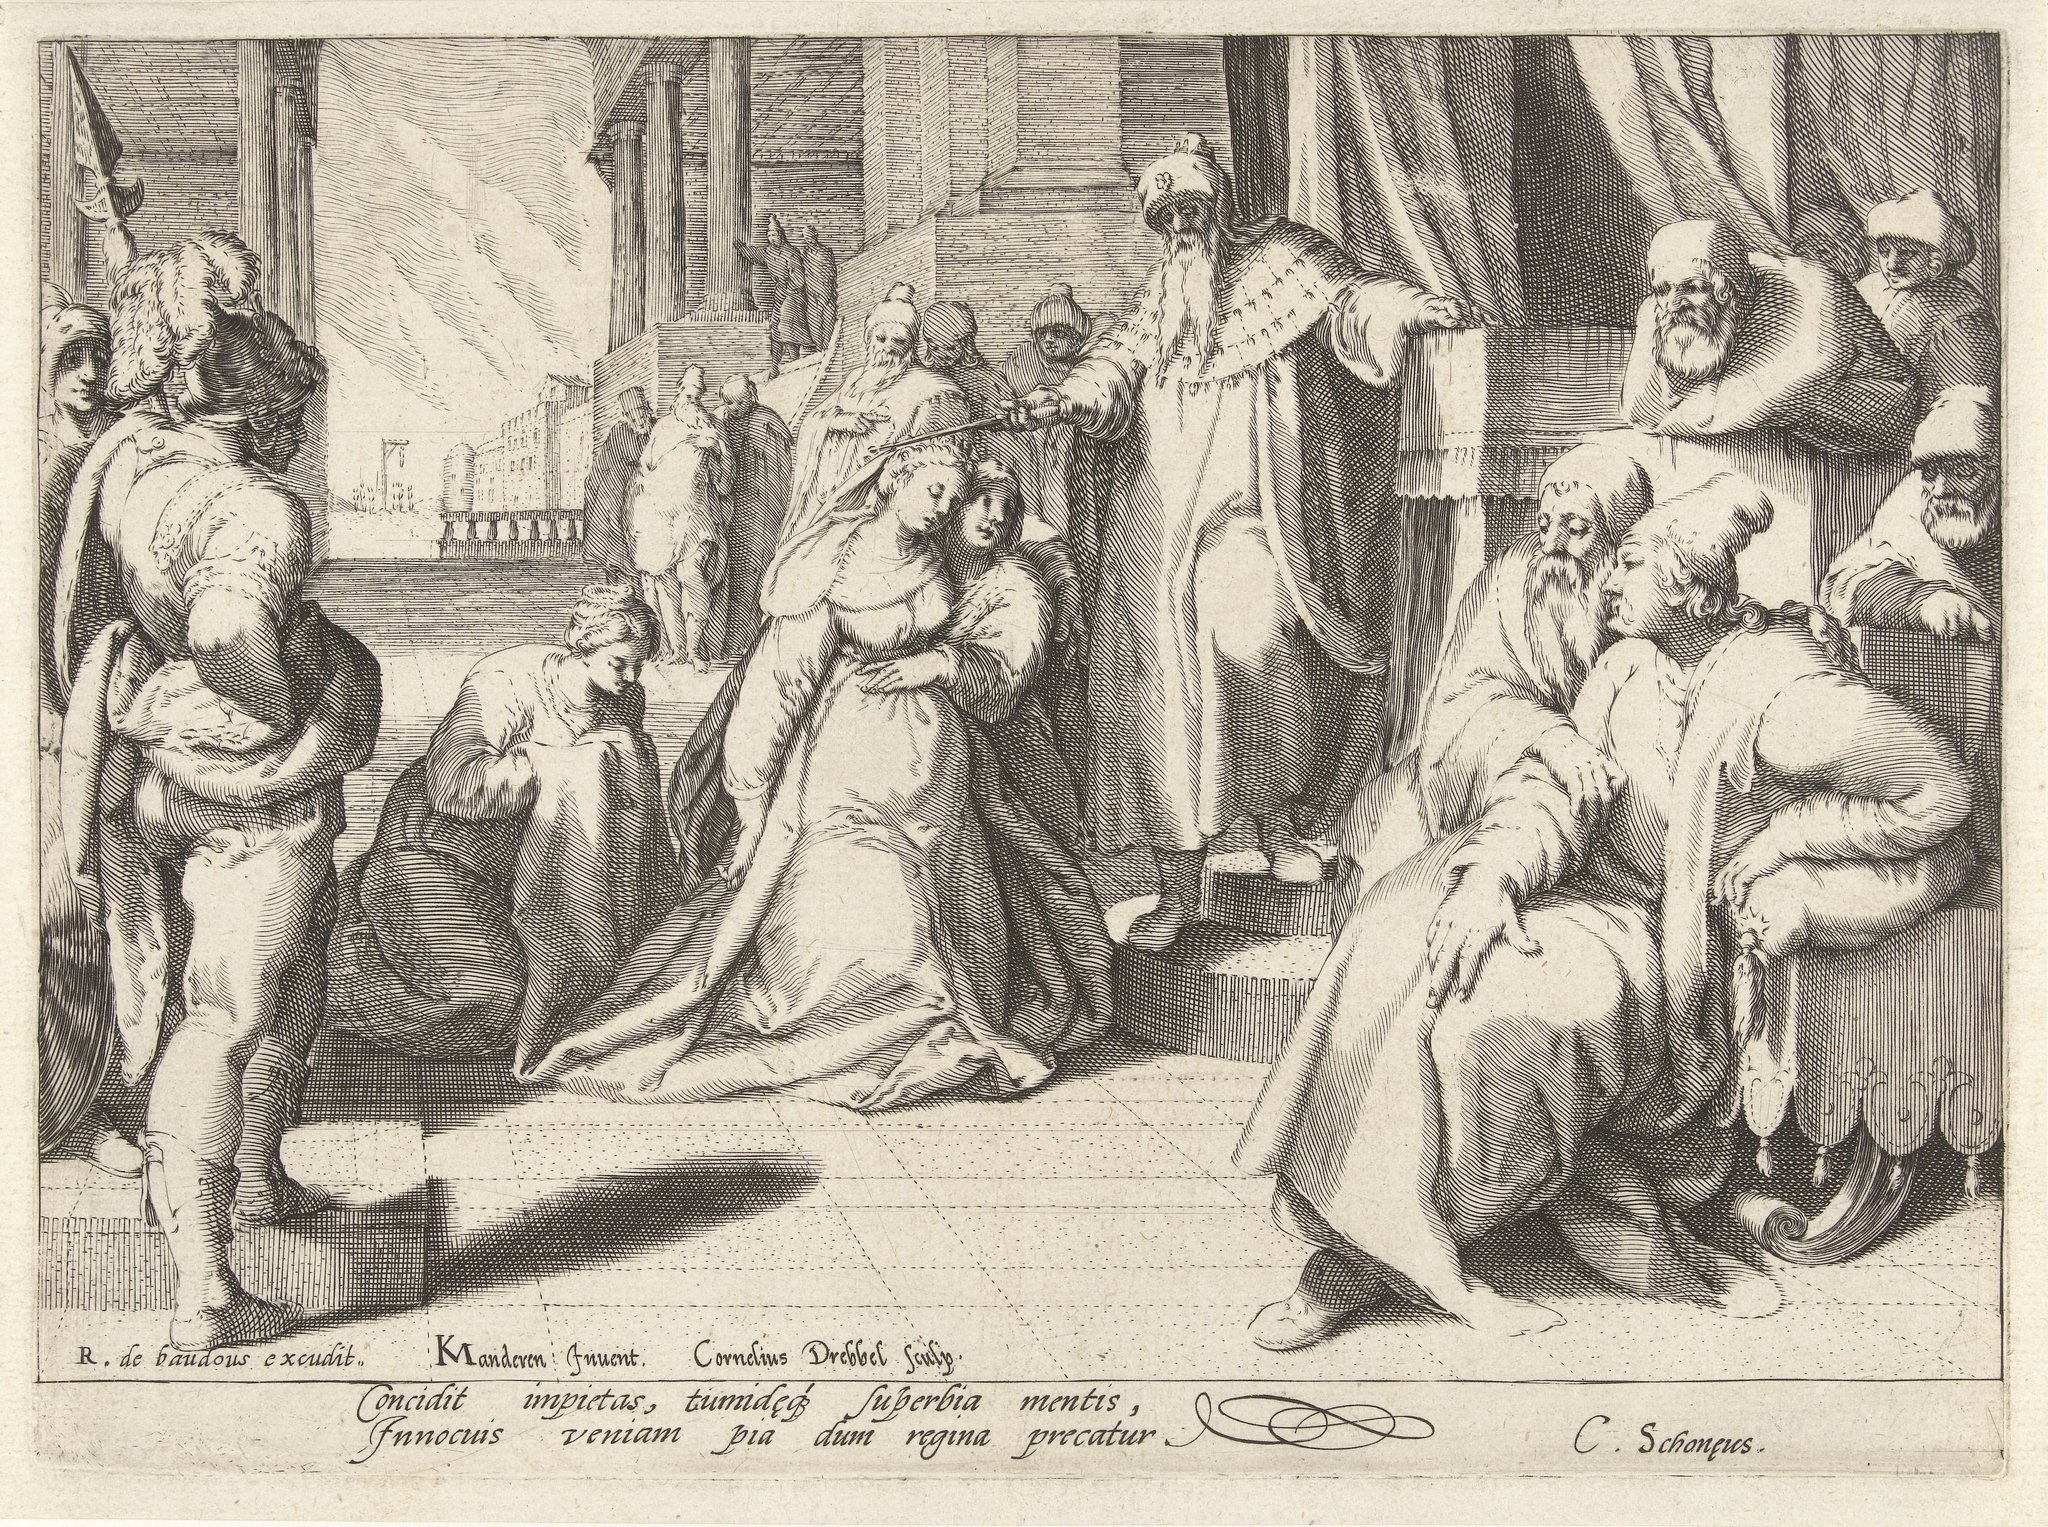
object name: print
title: Ester voor Ahasveros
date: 1597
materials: paper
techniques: engraving, etching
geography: netherlands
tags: esther before ahasuerus (esther 5:1-4), ahasuerus holds out his sceptre to esther (esther usually kneeling), esther swoons on the shoulder of one of her maids (esther 15:7)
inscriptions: collector's mark: Lugt 2228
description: Ester knielt voor koning Ahasveros. Een oudere vrouw steunt haar. De koning laat zijn scepter op haar hoofd zakken als teken van genegenheid. Pendant van een prent met het Oordeel van Salomon.